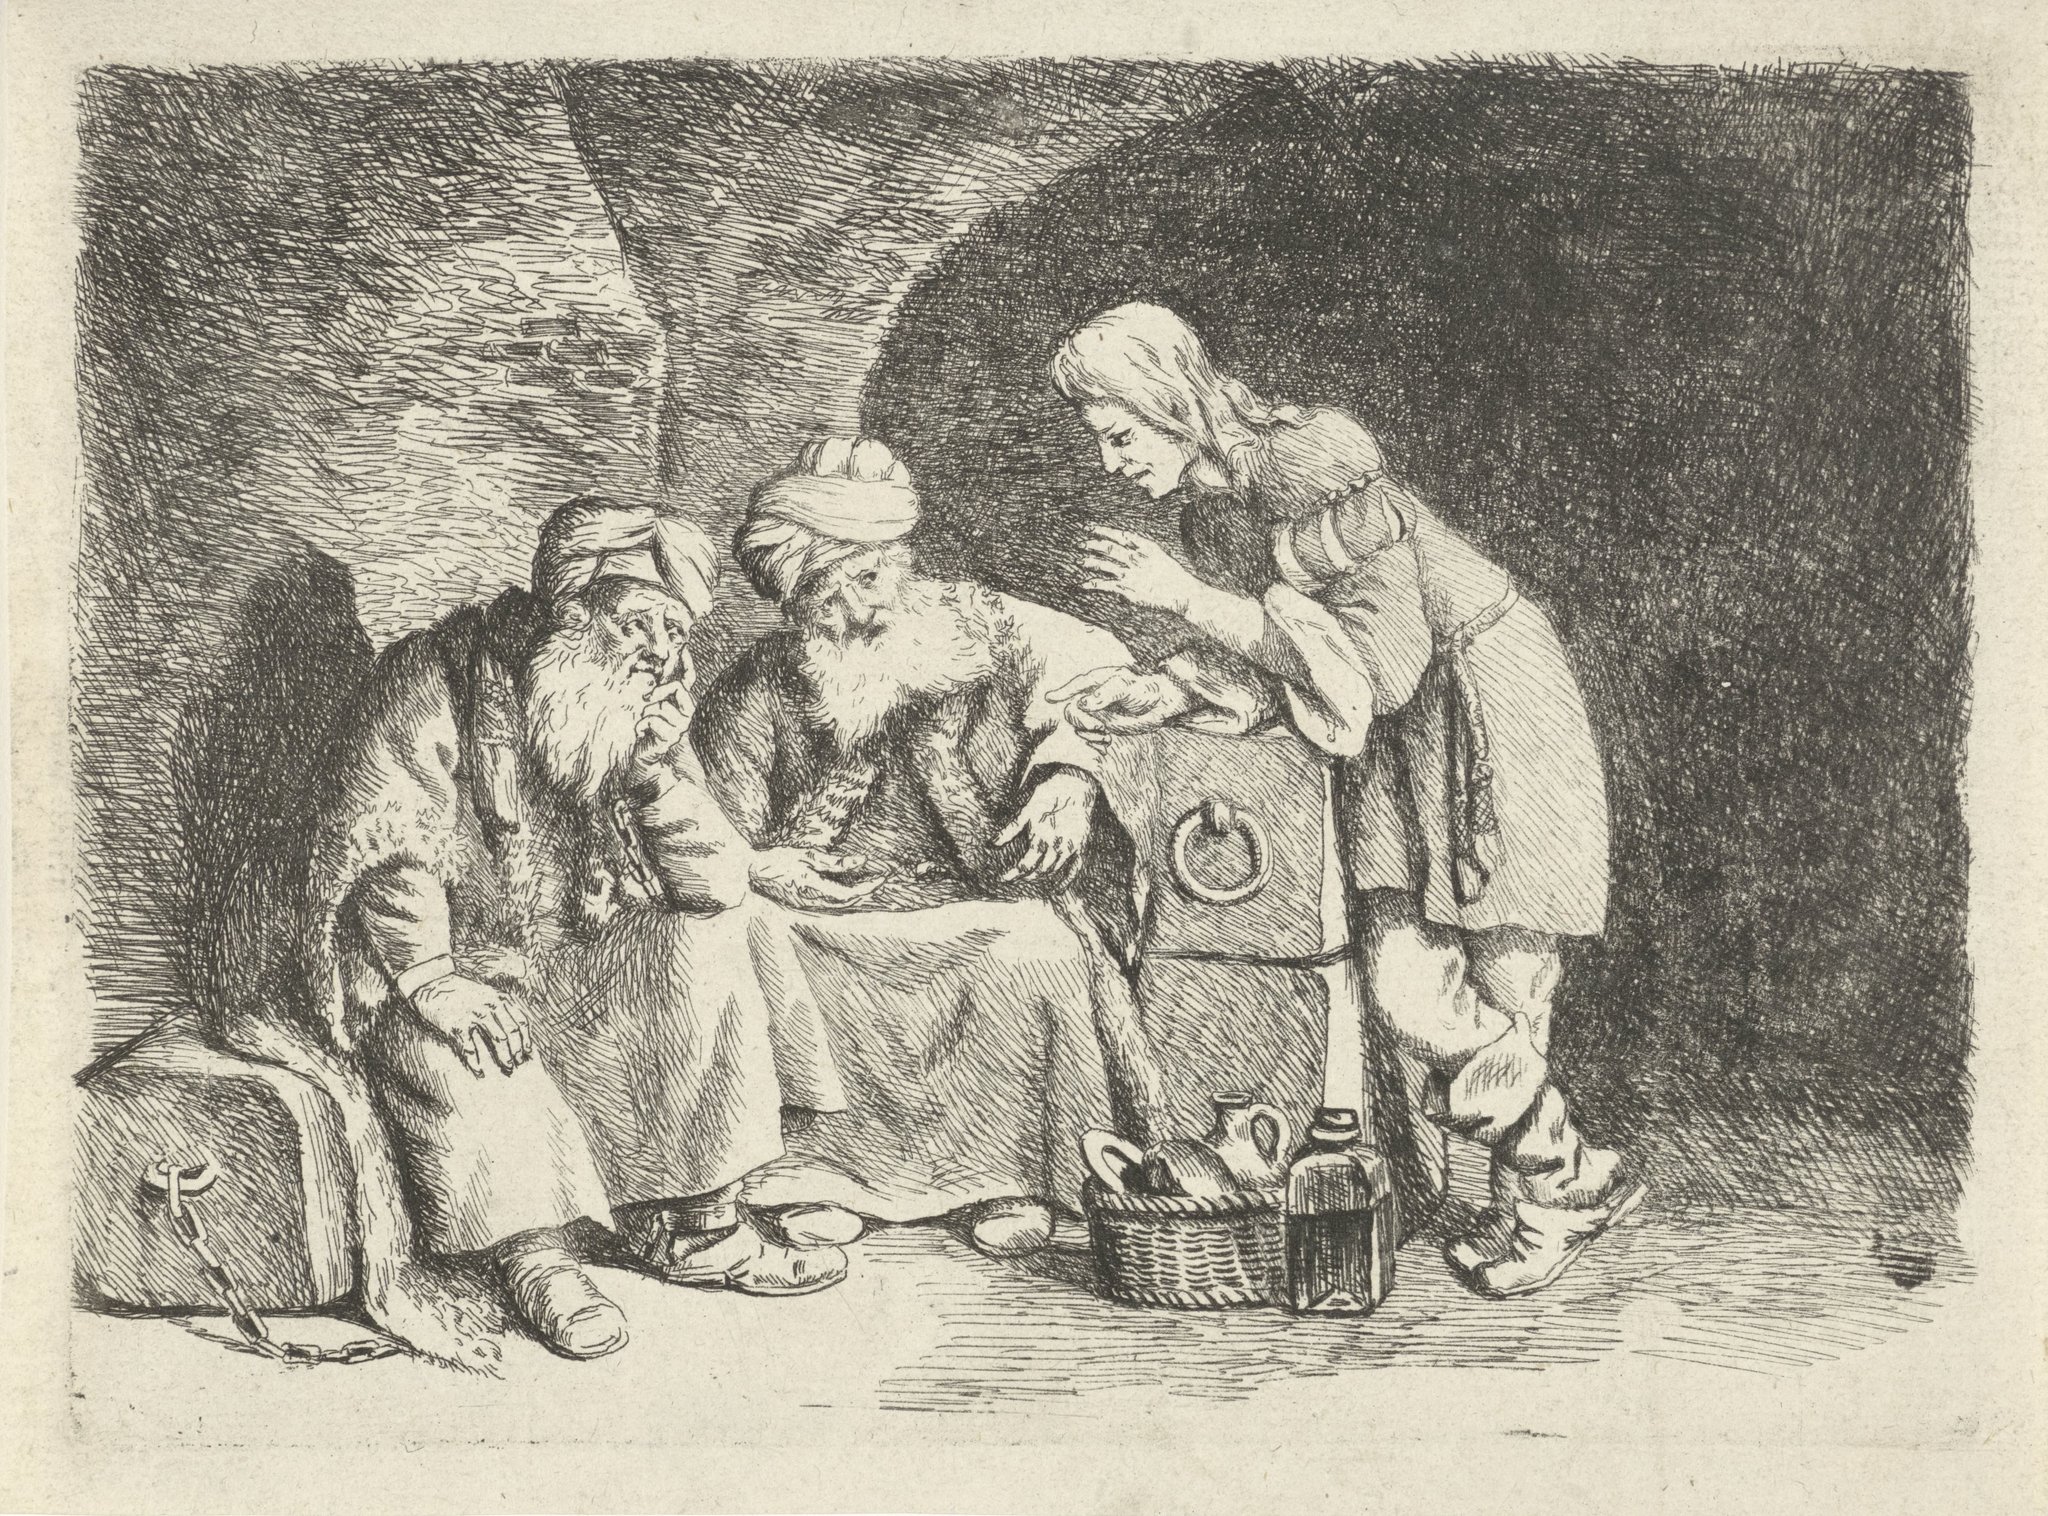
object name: print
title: Jozef verklaart de dromen van de bakker en de schenker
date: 1616-1719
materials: paper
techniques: etching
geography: netherlands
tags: joseph interpreting the dreams of the butler and the baker (the two dreams combined)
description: In de gevangenis geeft Jozef uitleg over de dromen van de schenker en de bakker, terwijl zij aandachtig luisteren. Hij voorspelt de twee mannen dat het niet goed zal aflopen met de bakker, en wel met de schenker. In beide gevallen kreeg hij gelijk.